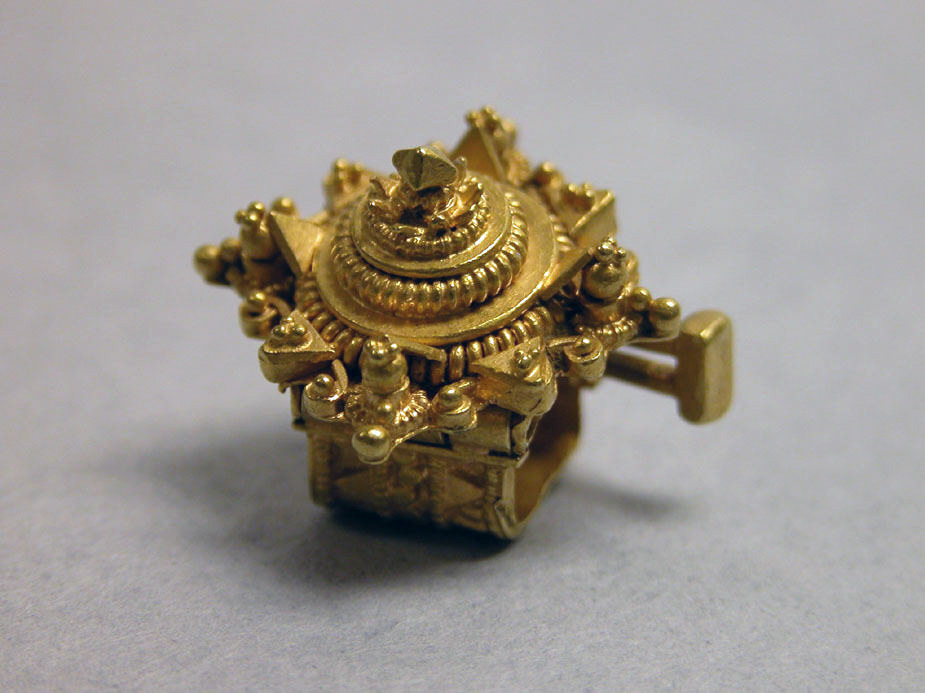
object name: earclip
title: Hinged Earclip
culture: indonesian, javanese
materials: gold